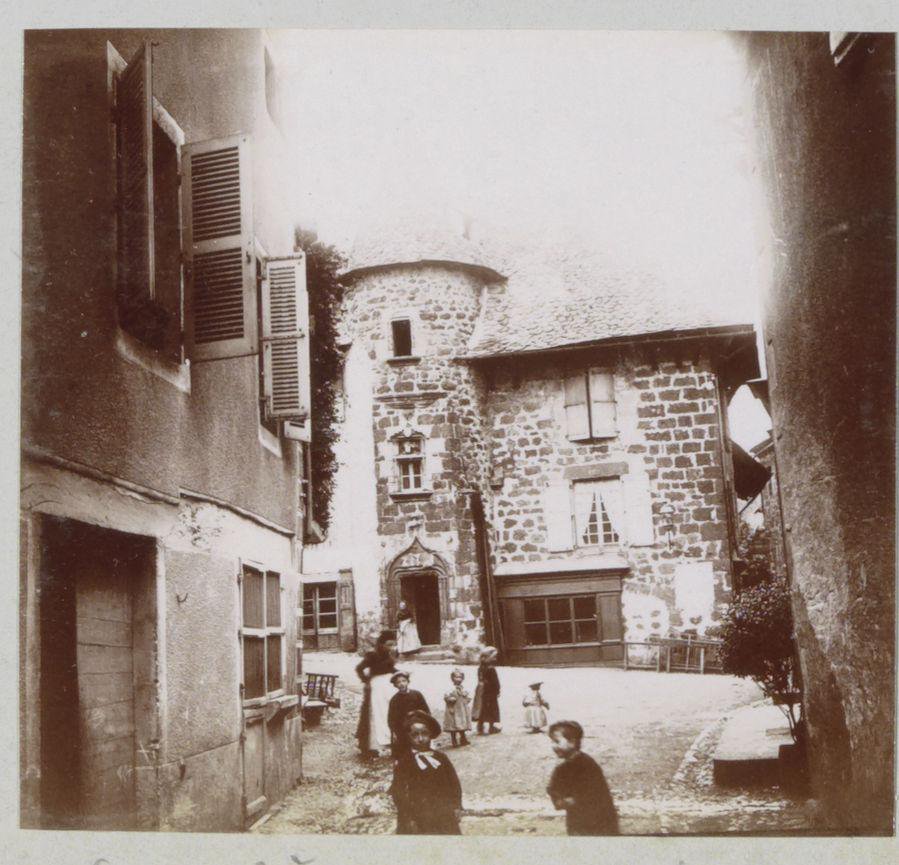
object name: photograph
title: Kinderen op straat in Vic-sur-Cère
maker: delizy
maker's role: manufacturer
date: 1902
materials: paper, photographic support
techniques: gelatin silver print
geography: vic-sur-cère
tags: child, street (+ city(-scape) with figures, staffage)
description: Onderdeel van Fotoalbum van een Franse amateurfotograaf met opnames van uitstapjes in Frankrijk, Spanje, België, Luxemburg en Nederland, de eerste automobielen en autoraces.